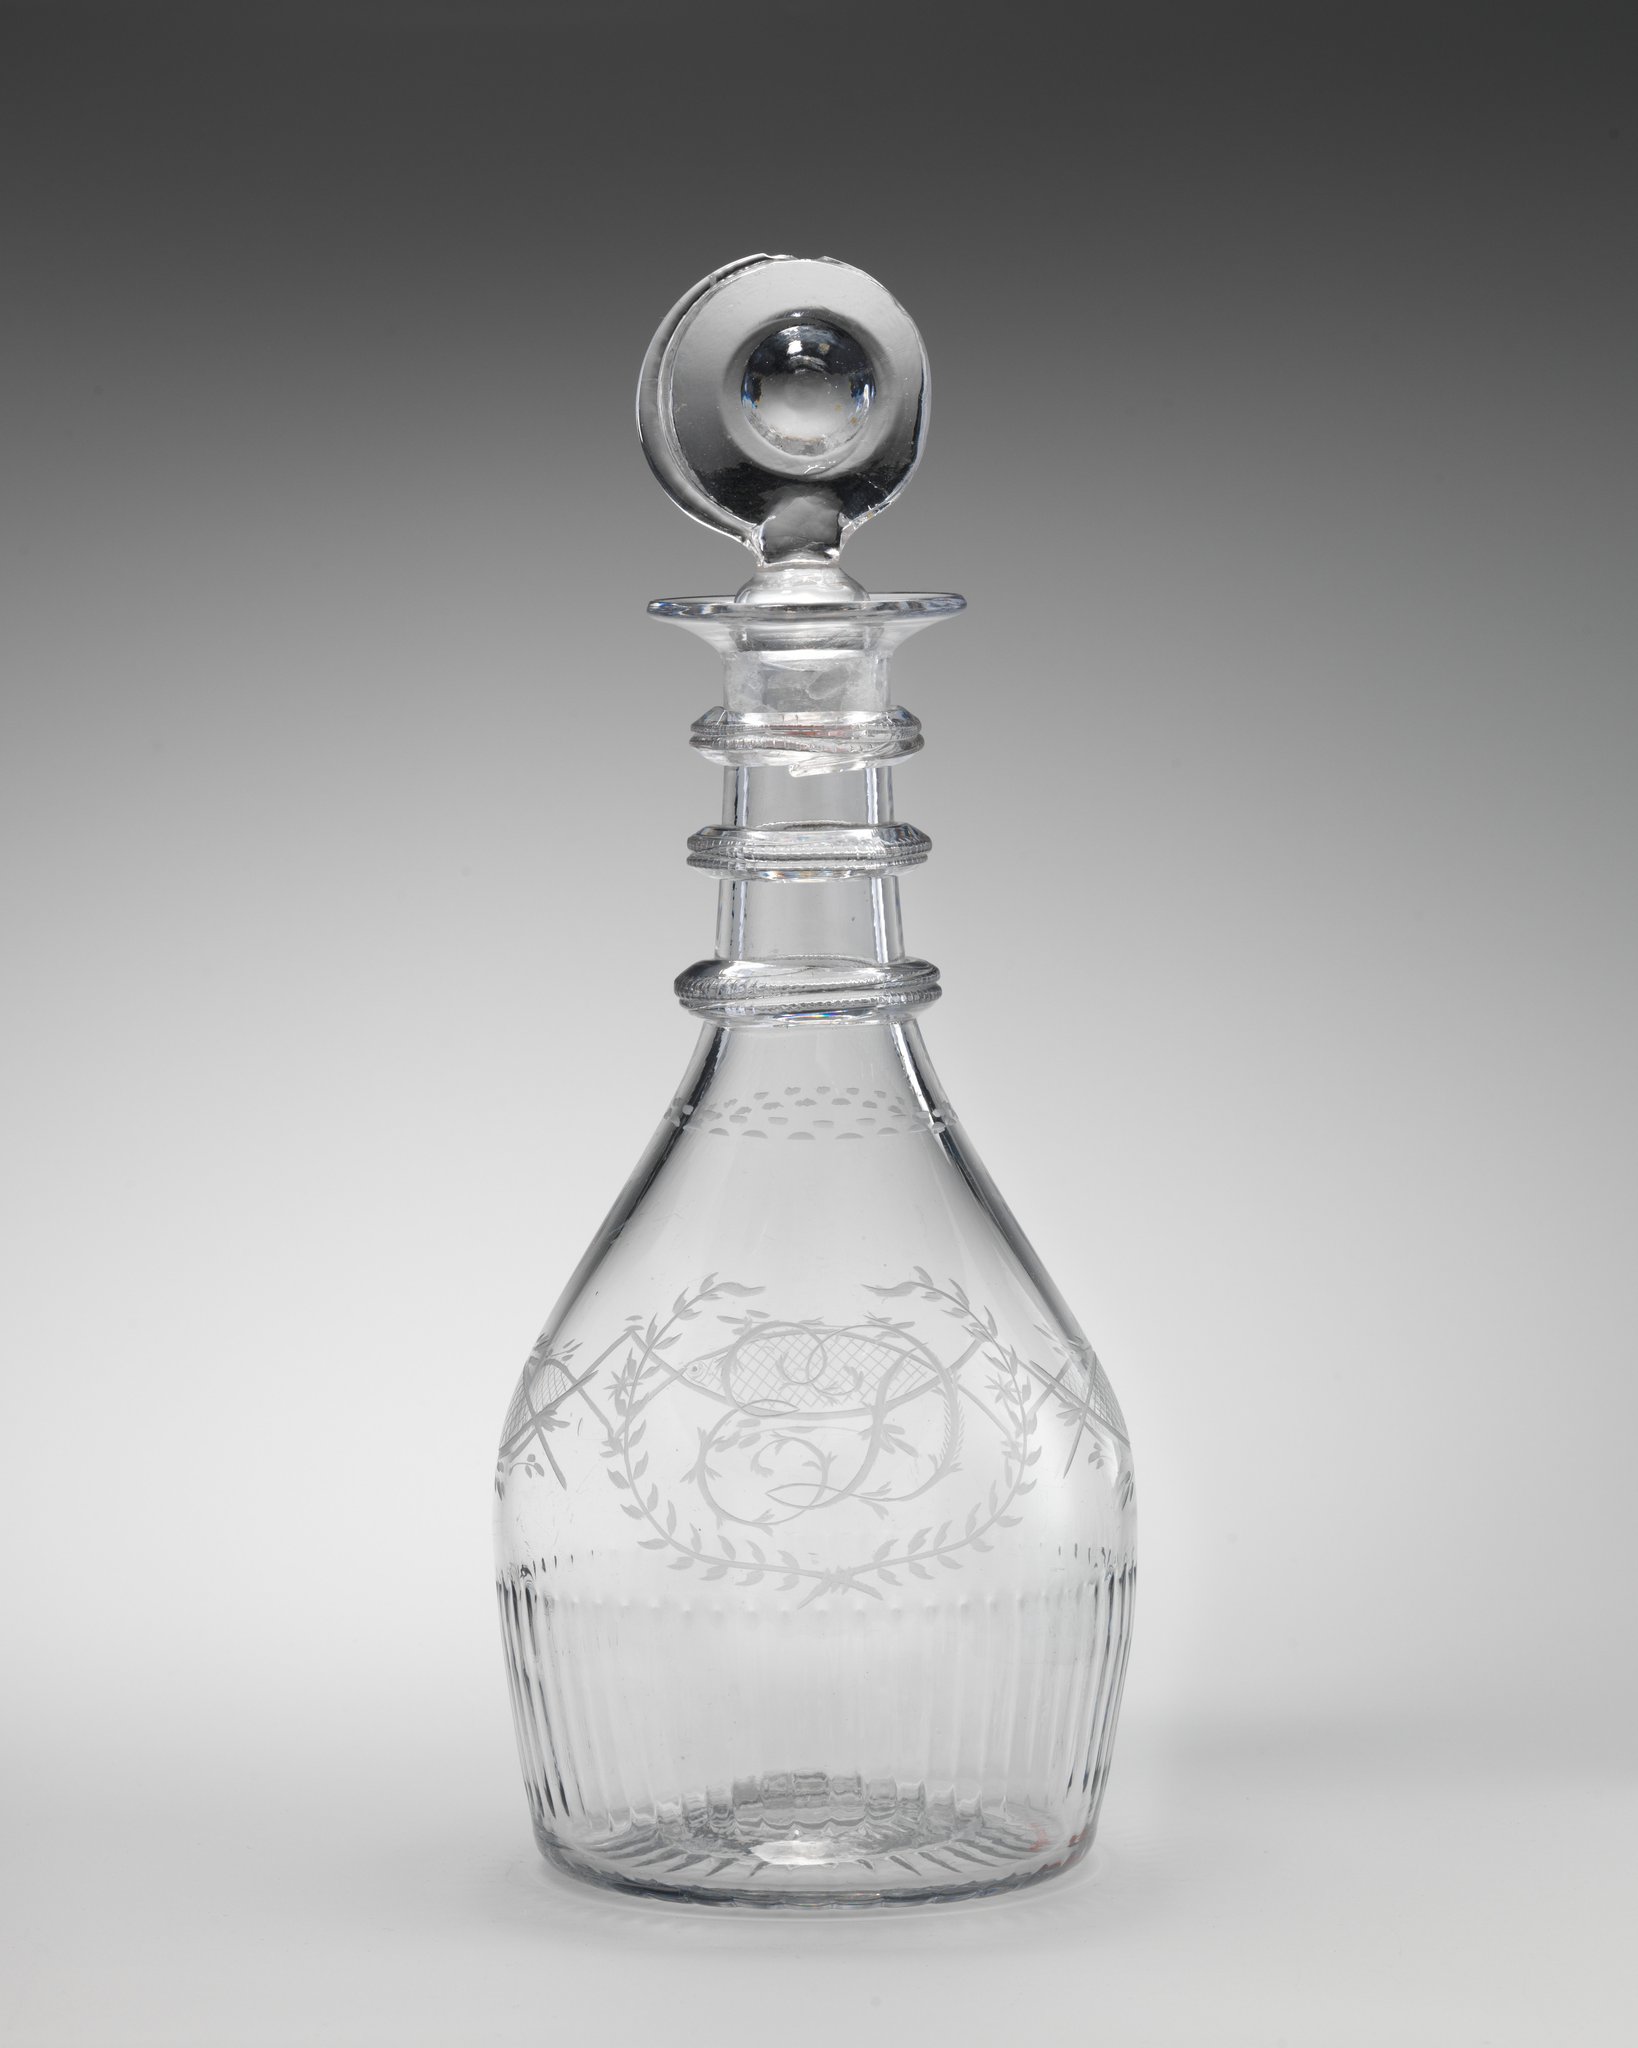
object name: decanter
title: Decanter (one of a pair)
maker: cork glass company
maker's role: maker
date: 1783-1818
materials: glass